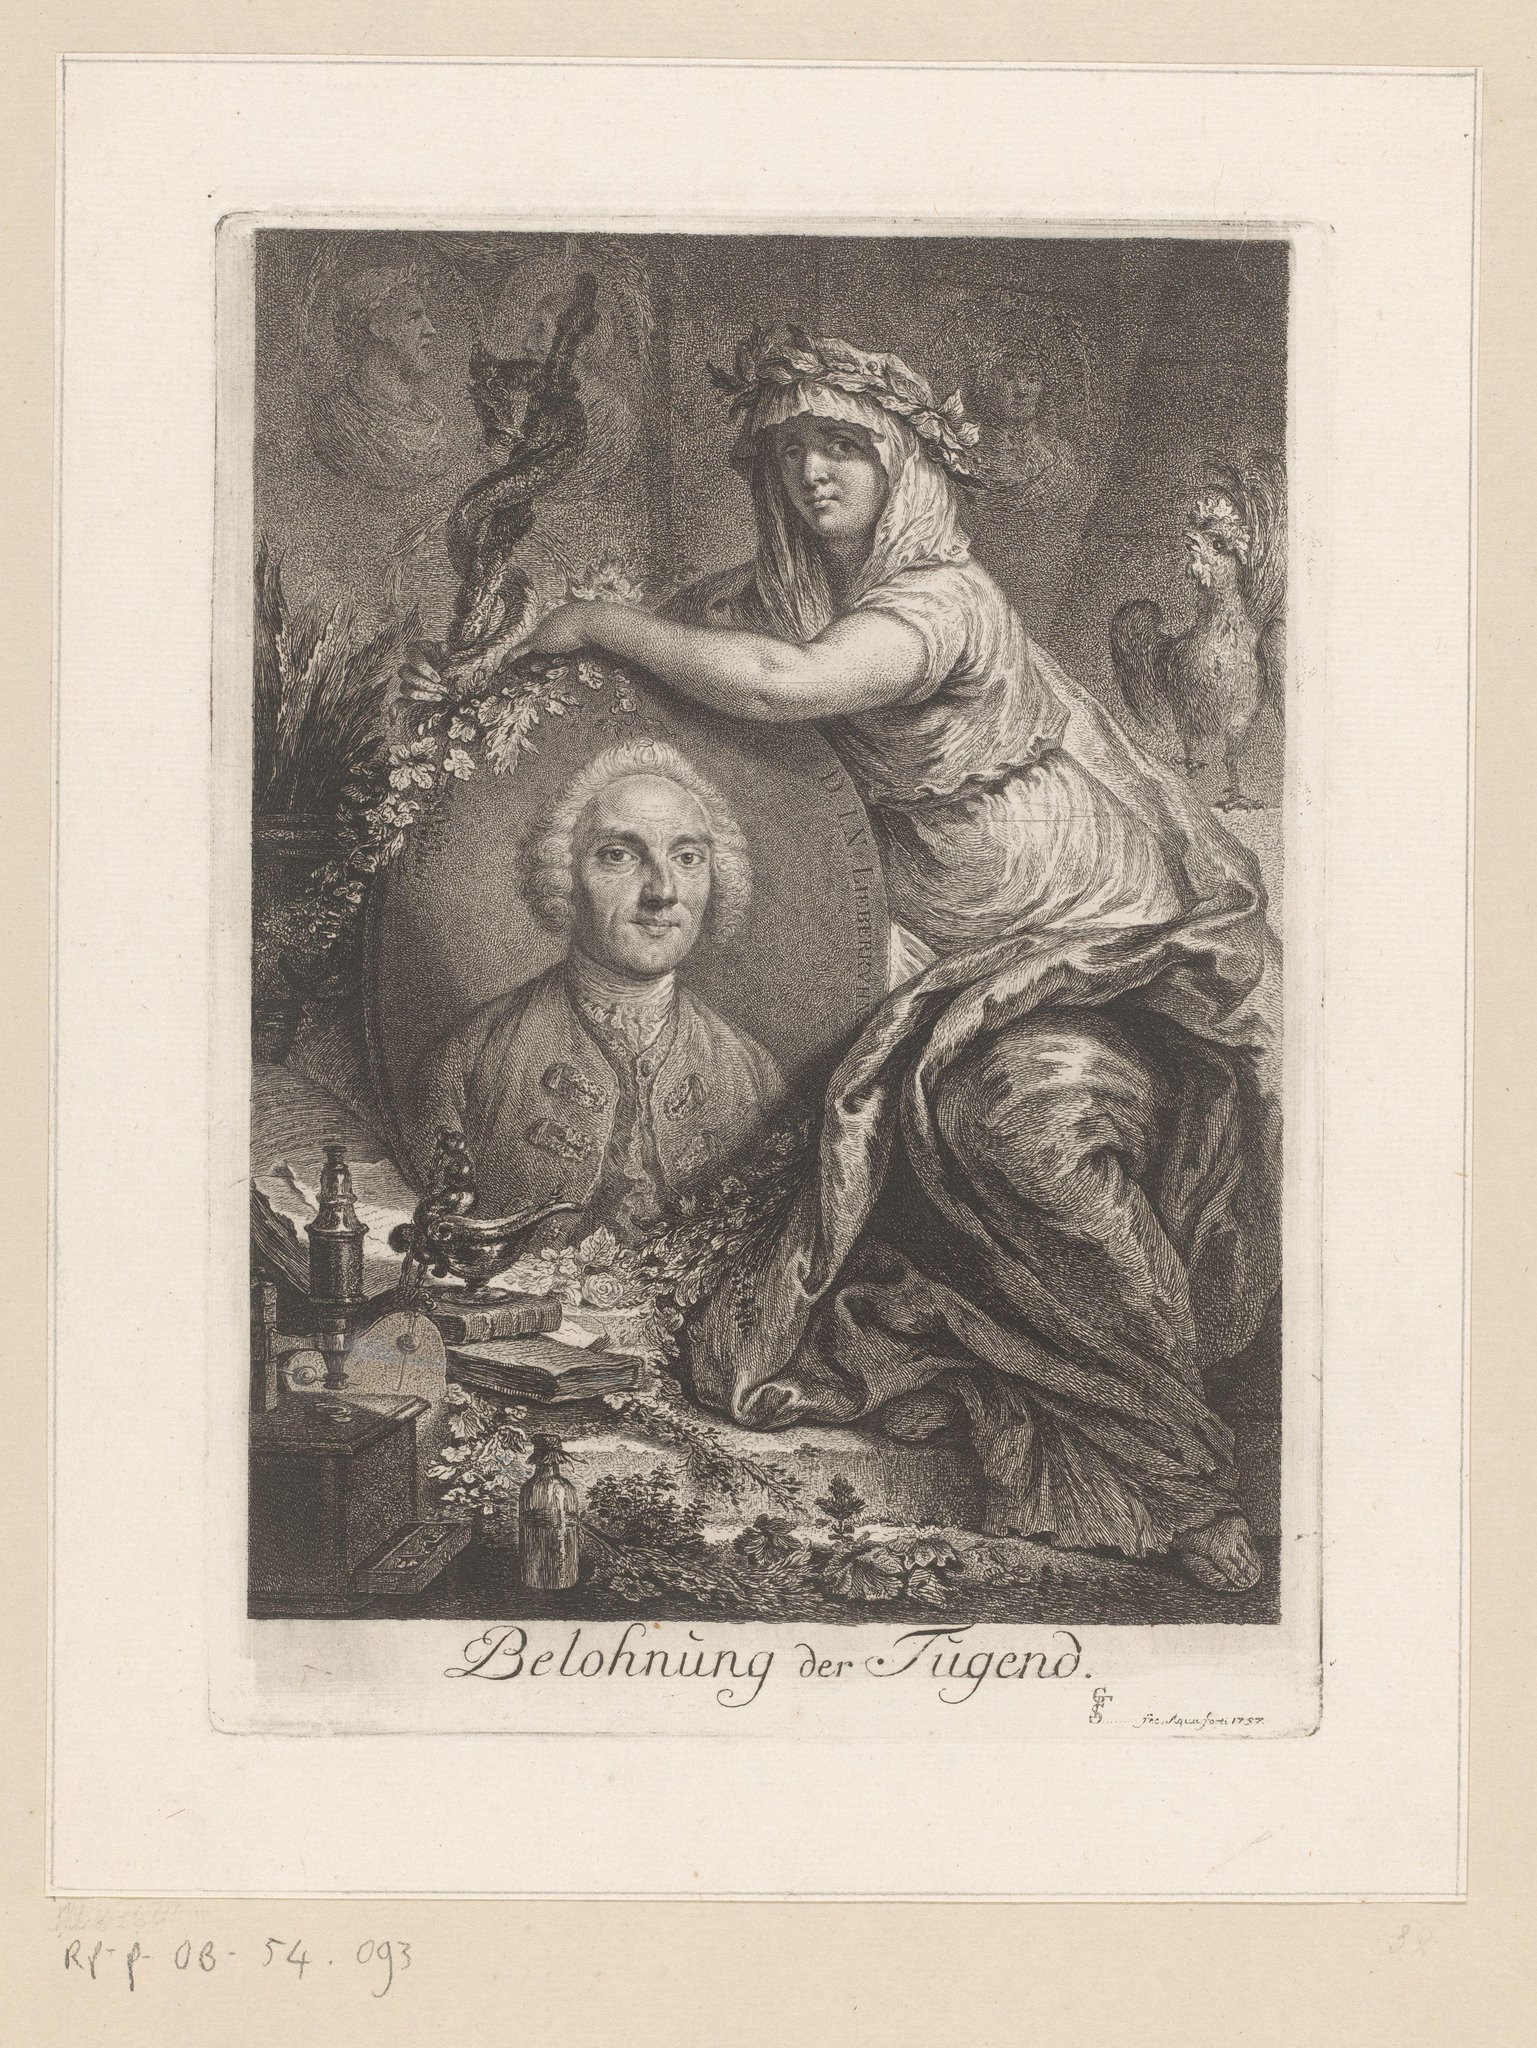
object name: print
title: Portret van Johann Nathanael Lieberkühn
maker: georg friedrich schmidt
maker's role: draughtsman, print maker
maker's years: 1712-1775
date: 1757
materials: paper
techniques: etching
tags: historical persons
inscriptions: collector's mark: Lugt 240